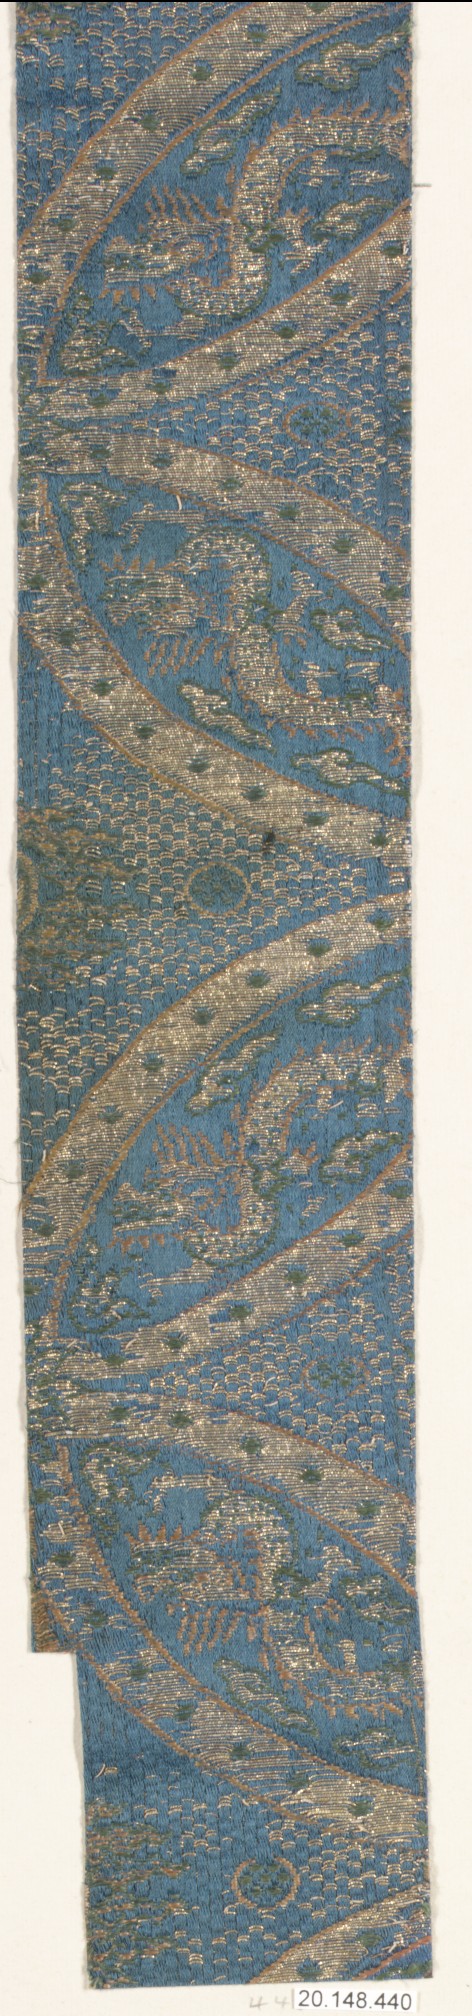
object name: piece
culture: chinese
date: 1701-1800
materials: silk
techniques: compound weave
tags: dragons